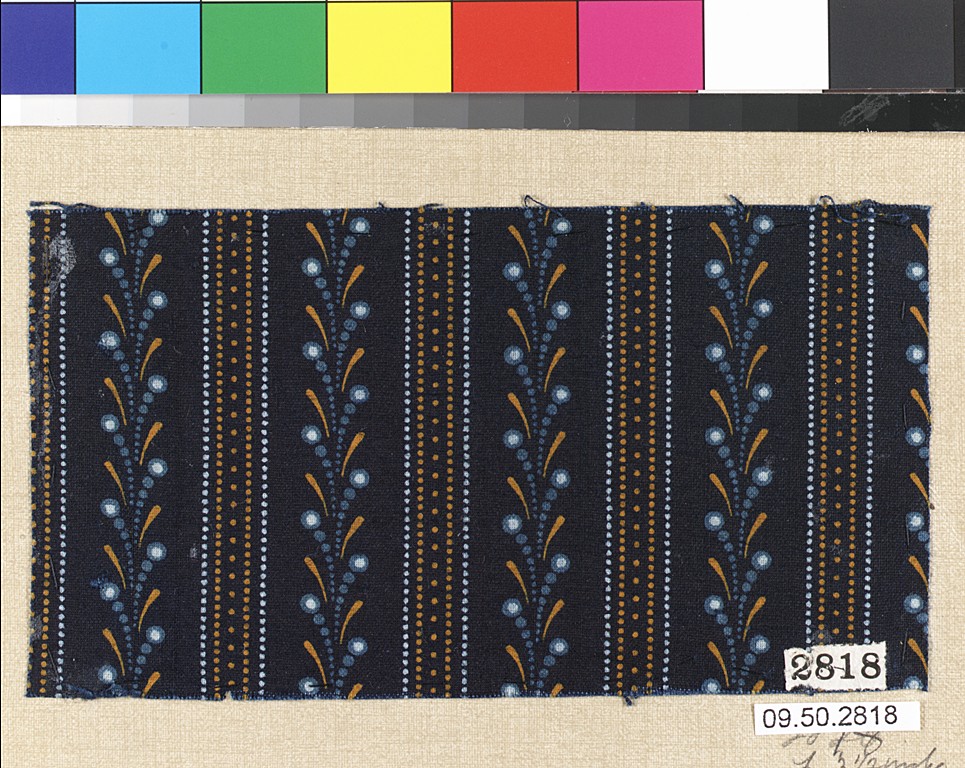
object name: piece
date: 1801-1900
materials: cotton